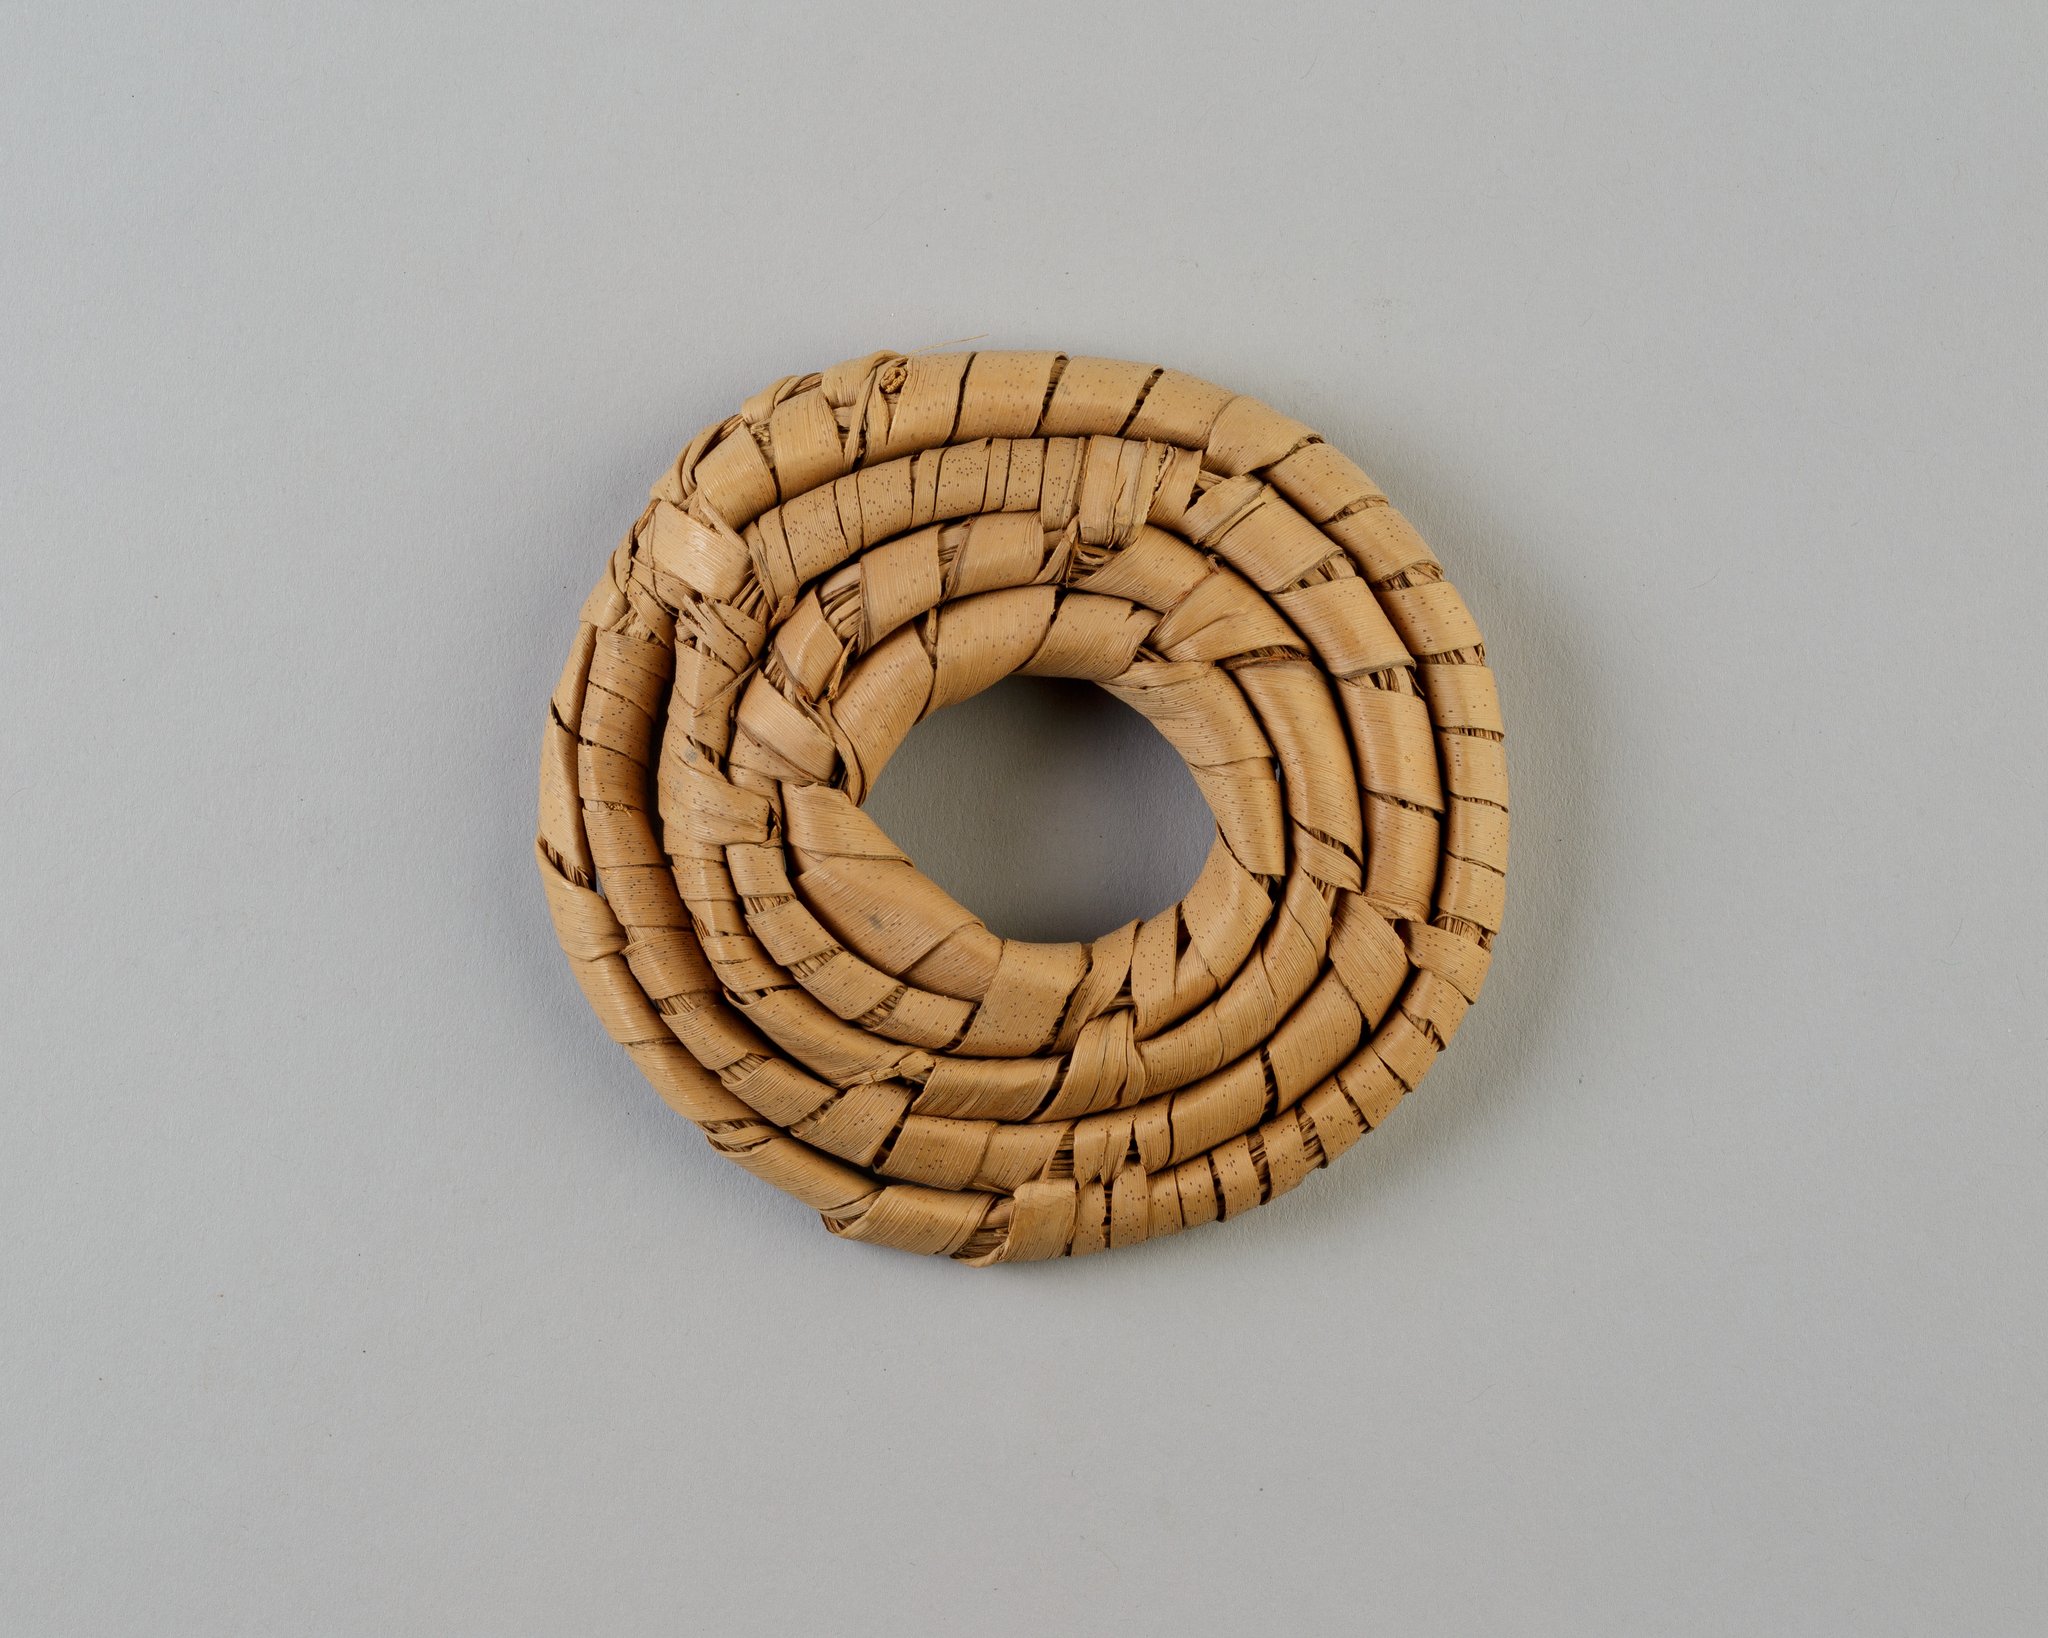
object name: basketry, model, senenmut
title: Pot Stand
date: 1479-1458 BCE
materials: leaf, fiber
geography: egypt